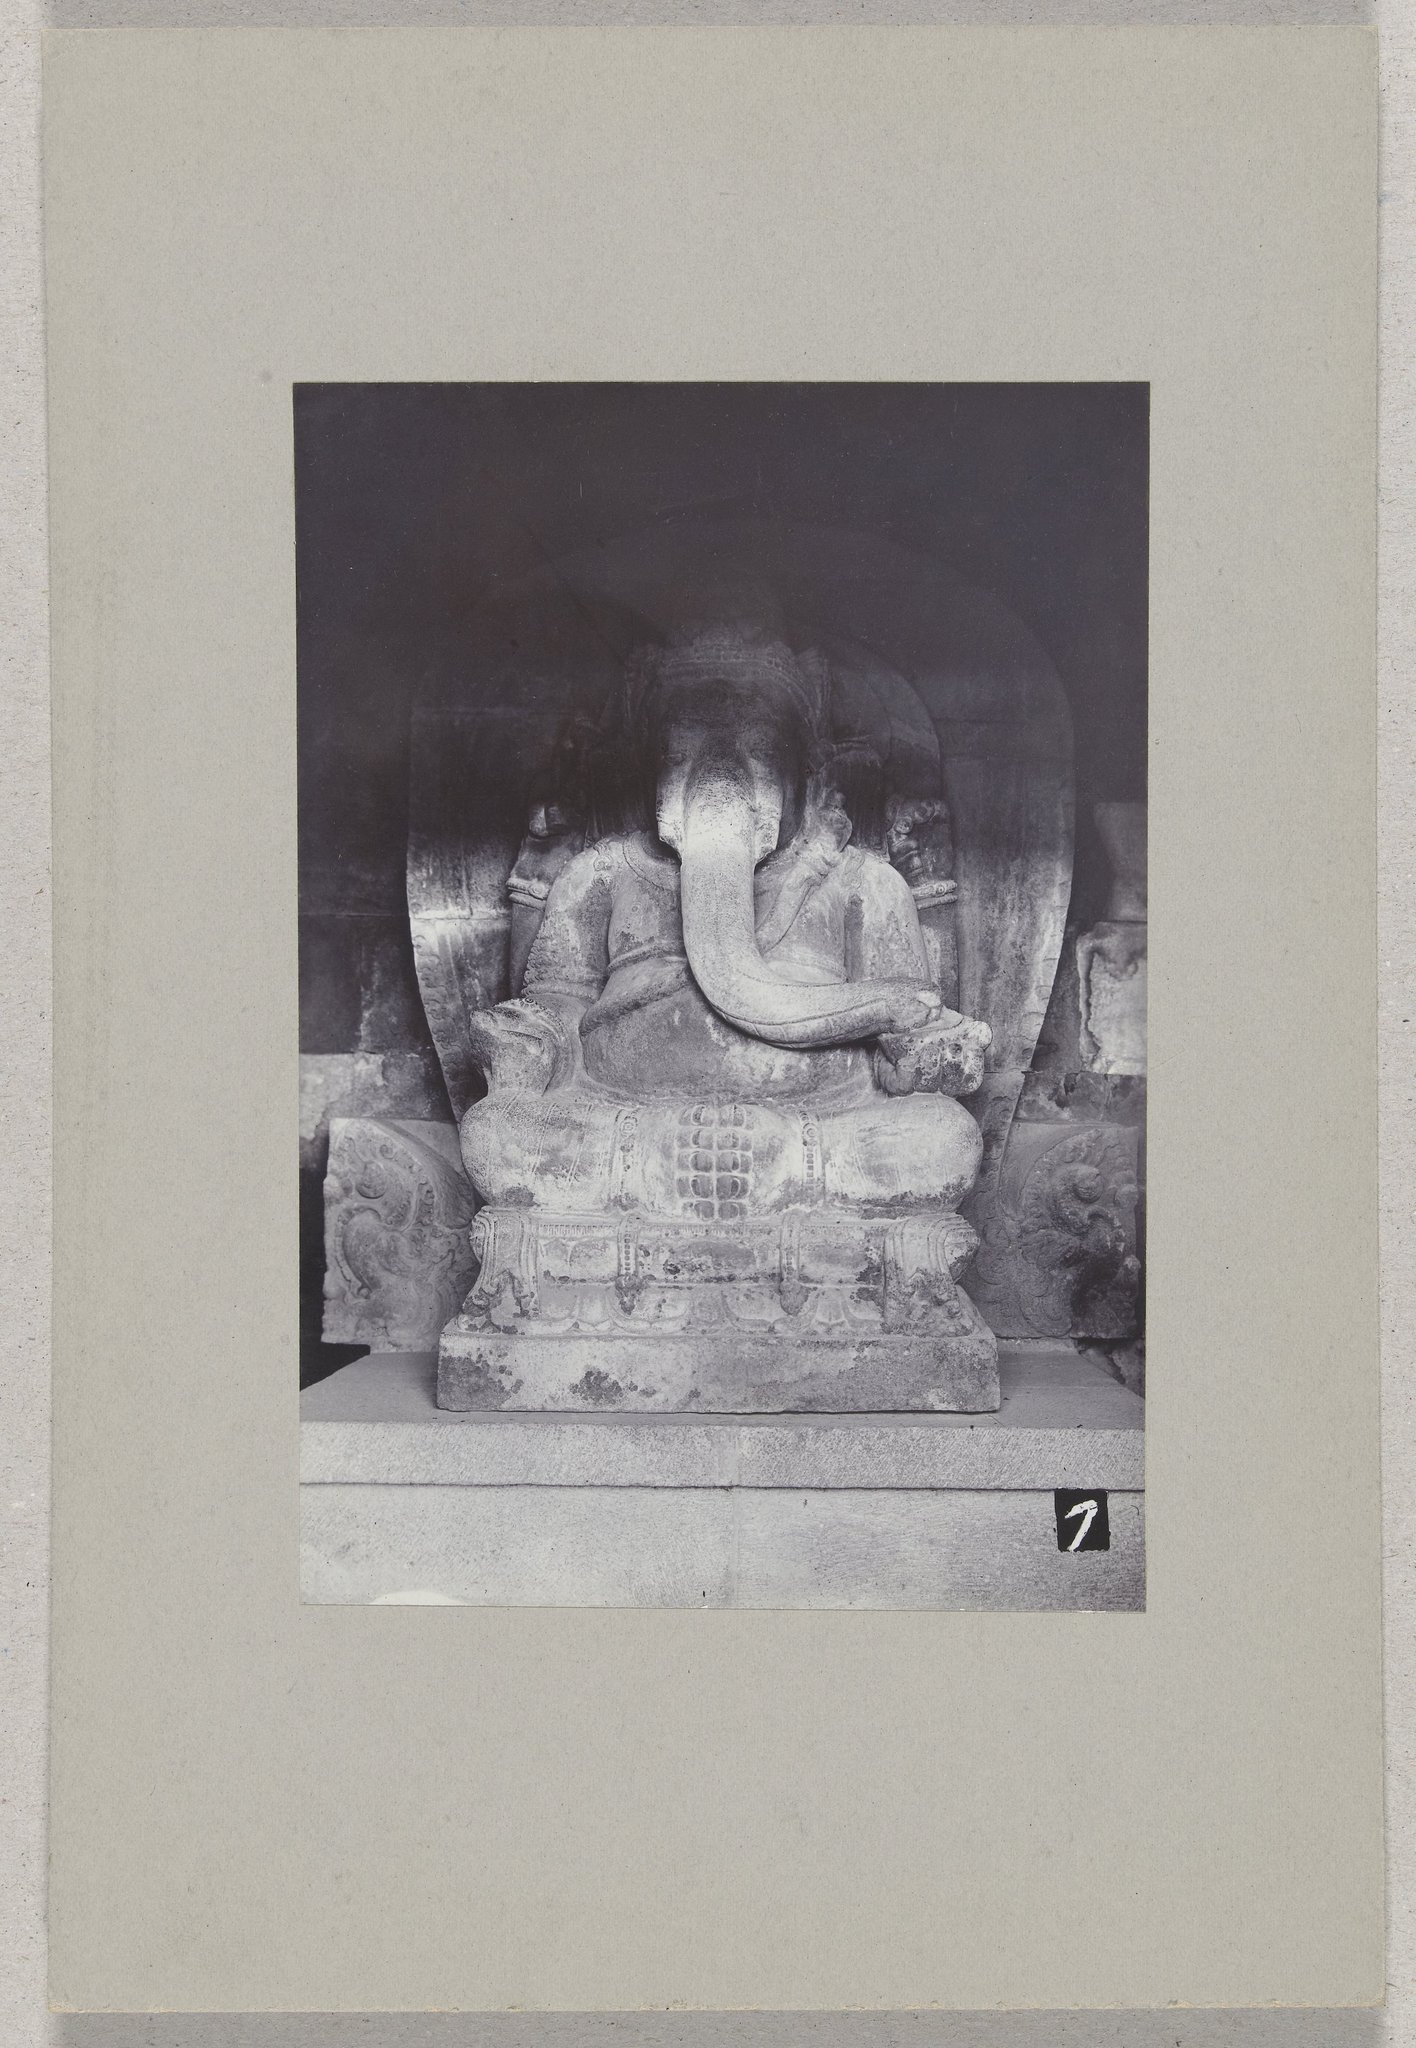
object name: photograph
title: Beeld in een zijnis van een tempel van Prambanan bij Jogyakarta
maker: Anonymous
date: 1895-1915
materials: cardboard, paper, photographic support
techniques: gelatin silver print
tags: indonesia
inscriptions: annotation: ‘85b Beeld in zijnis van tempel a’, number: ‘7’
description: Beeld in een zijnis van een tempel van Prambanan bij Jogyakarta, Nederlands-Indië